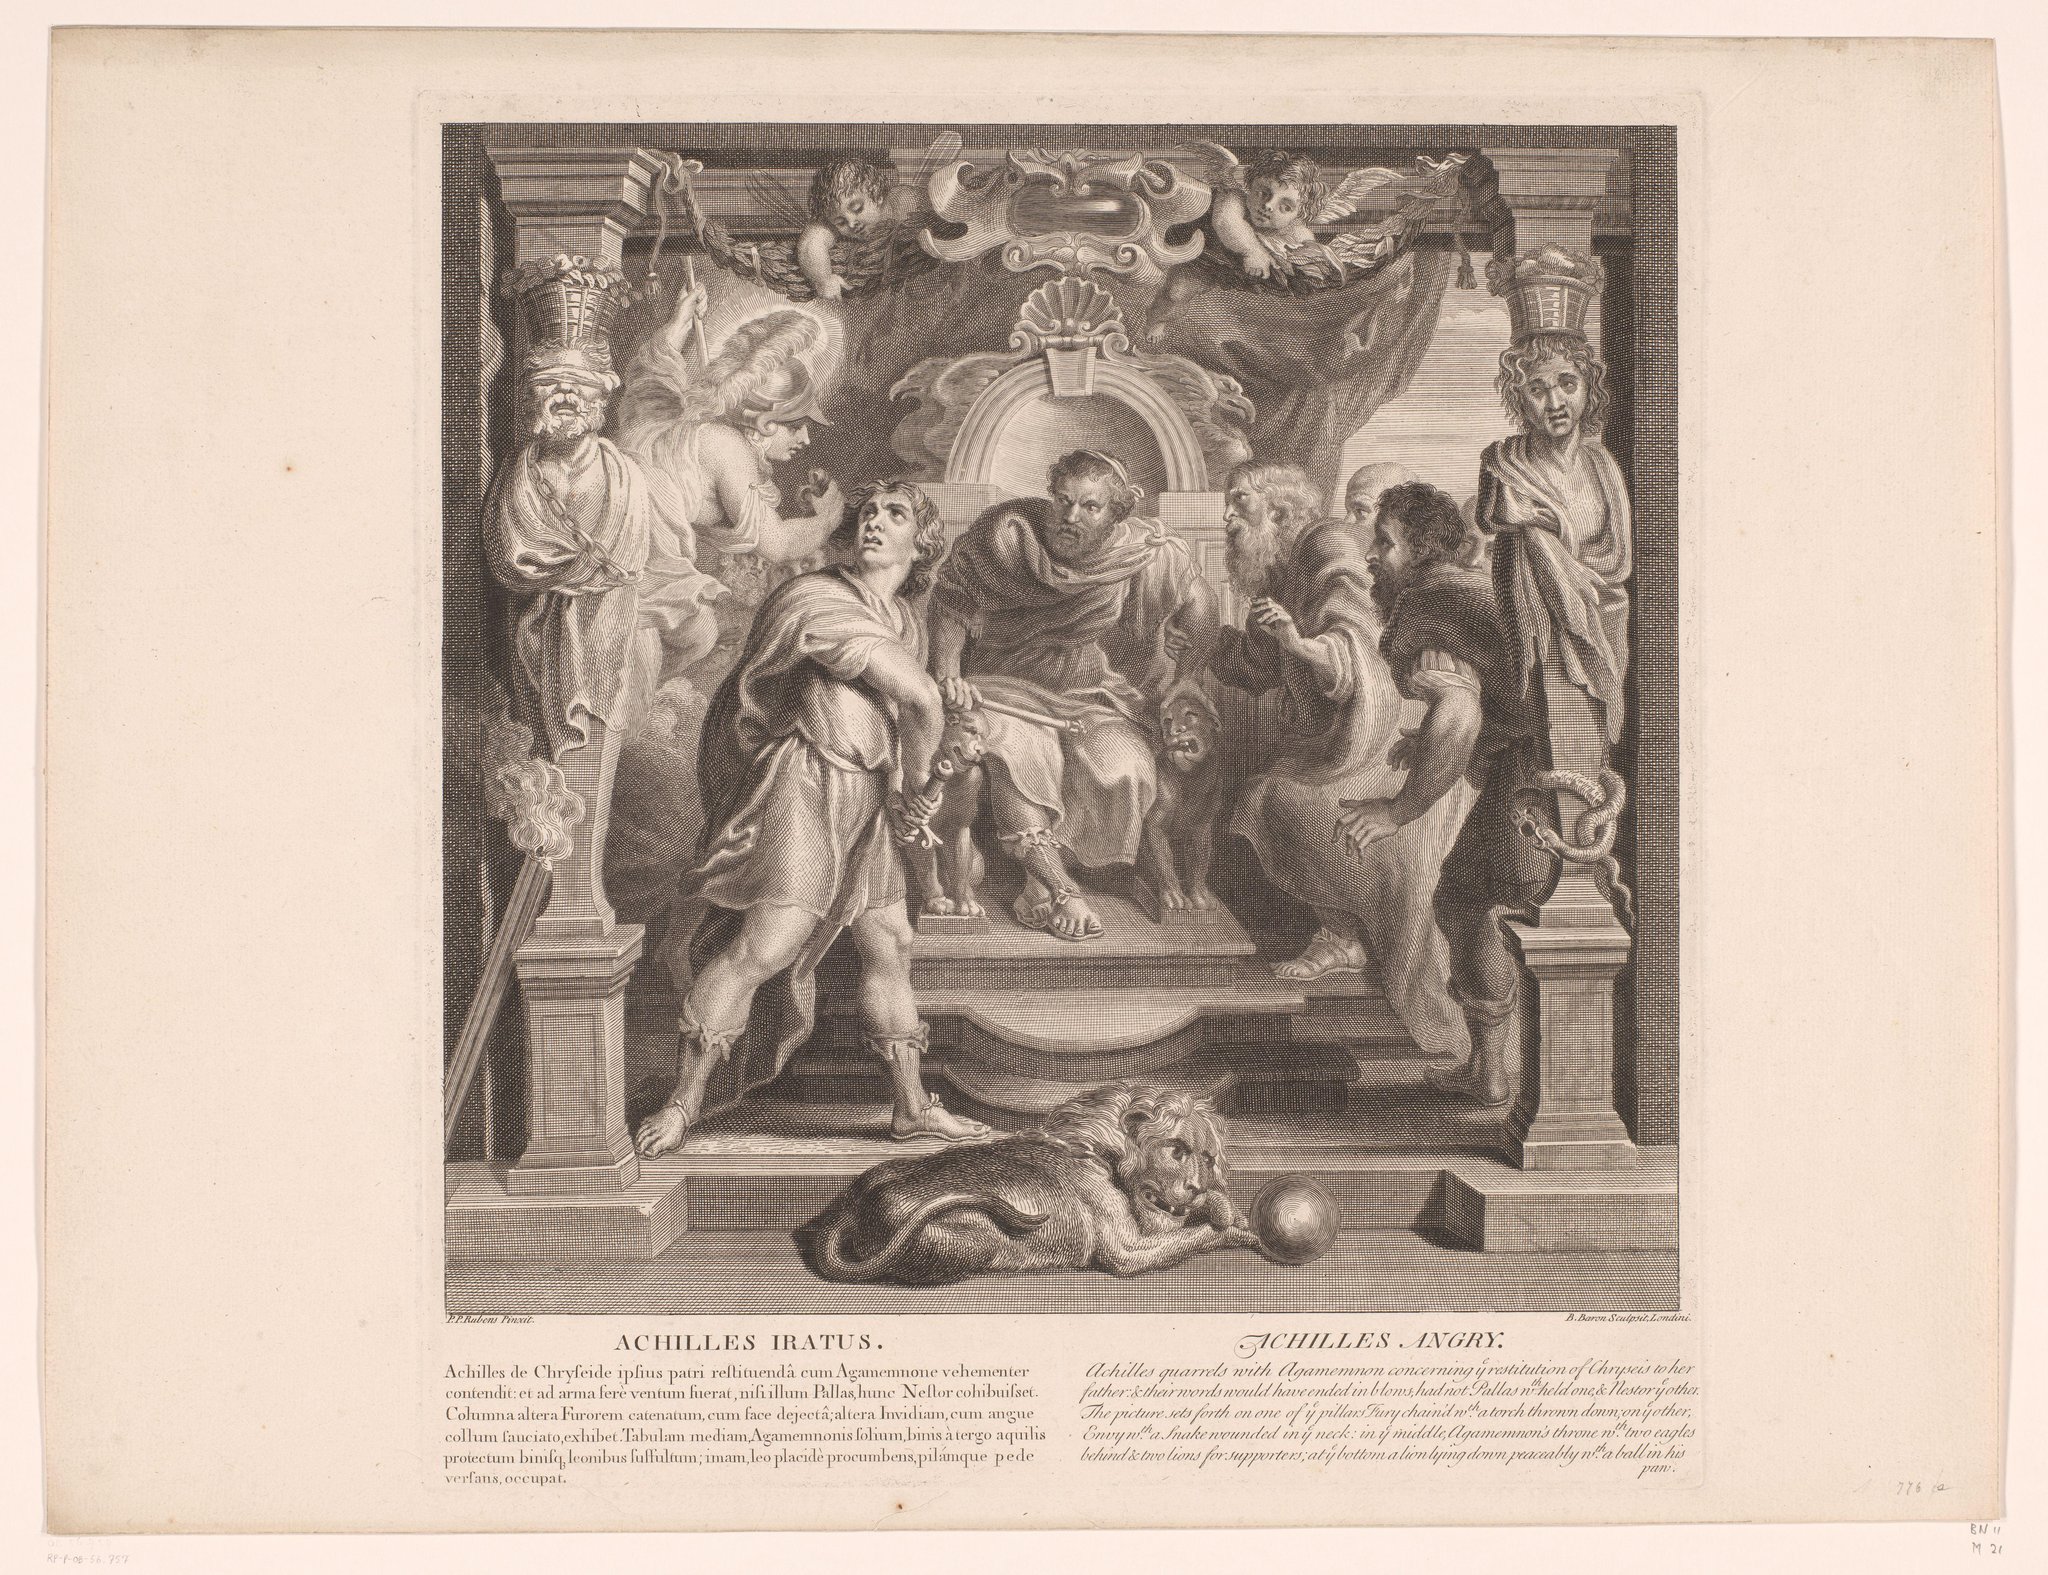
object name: print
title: Vie d'Achille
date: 1724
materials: paper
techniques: engraving, etching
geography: london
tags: (story of) achilles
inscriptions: watermark, collector's mark: Lugt 240